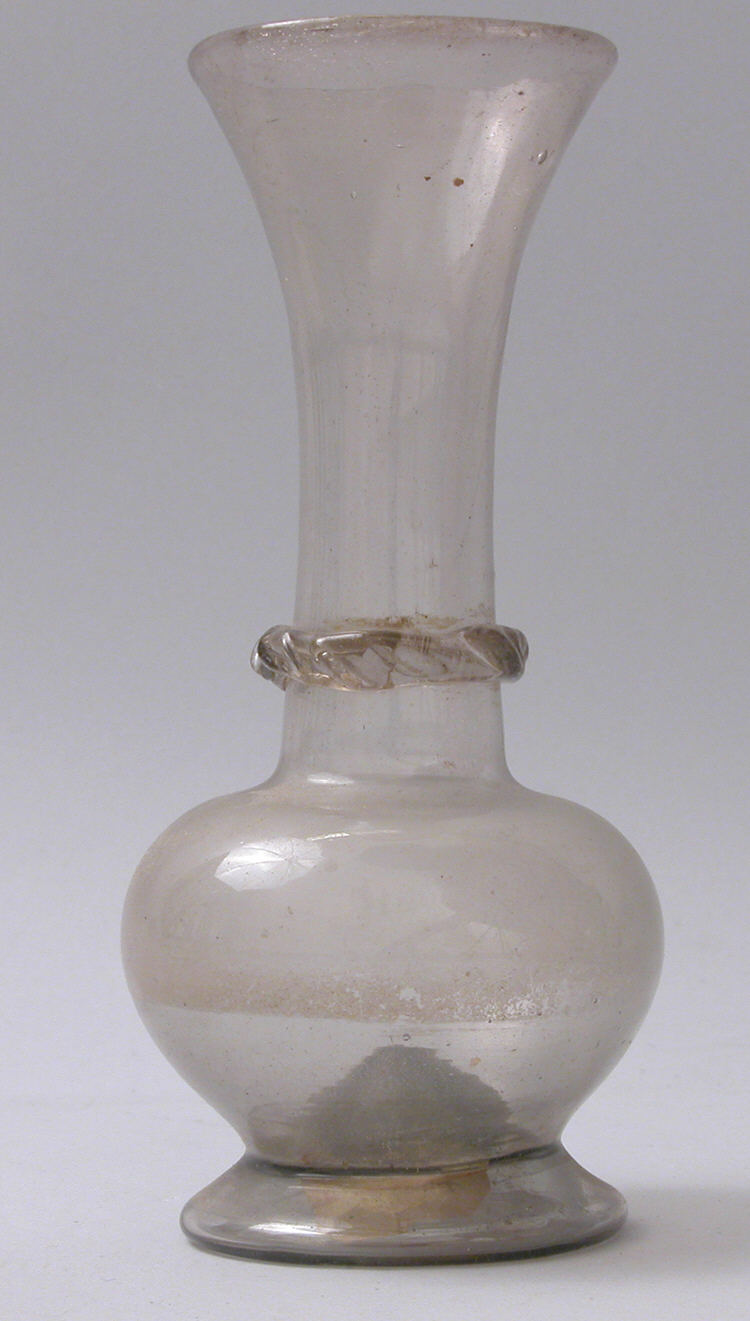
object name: vase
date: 1701-1900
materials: glass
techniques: glassblowing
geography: iran